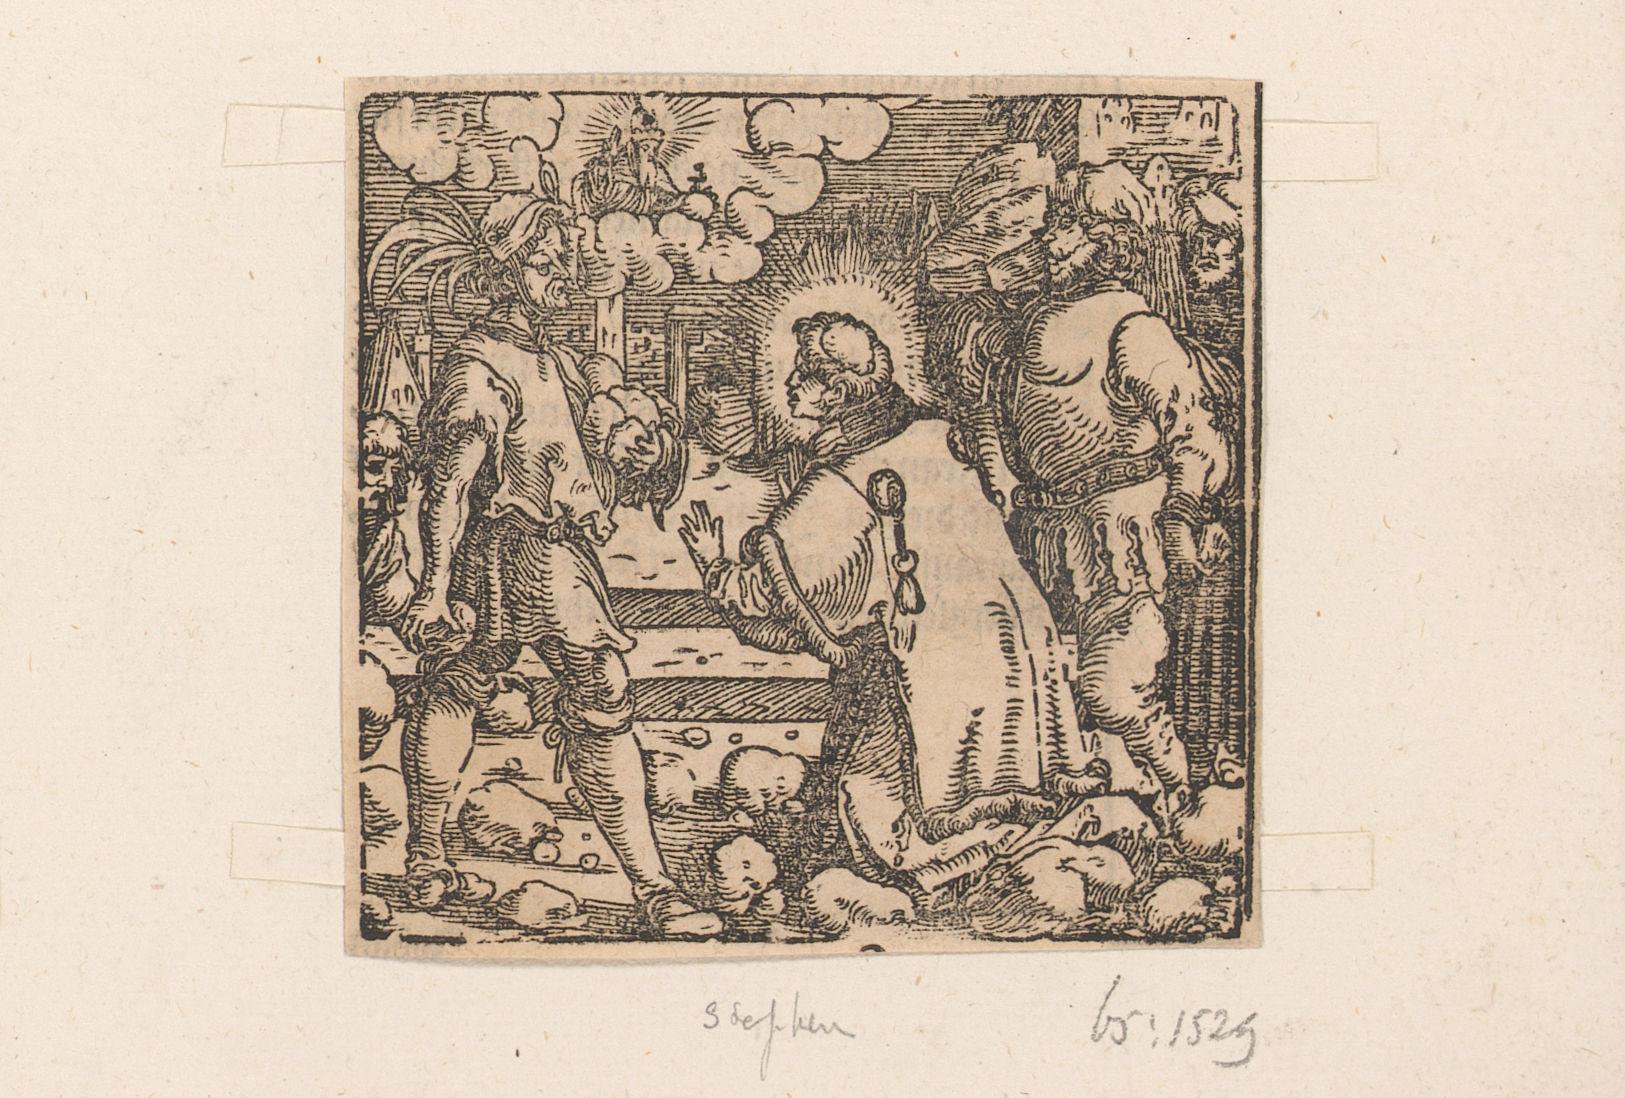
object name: album leaf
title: Steniging van Stefanus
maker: Anonymous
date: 1500-1536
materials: paper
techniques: woodcut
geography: germany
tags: the stoning of stephen; the witnesses lay down their clothes at saul's feet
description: Stefanus wordt gestenigd. Aan de hemel ziet hij God de Vader in een visioen. Prent maakt deel uit van een album.